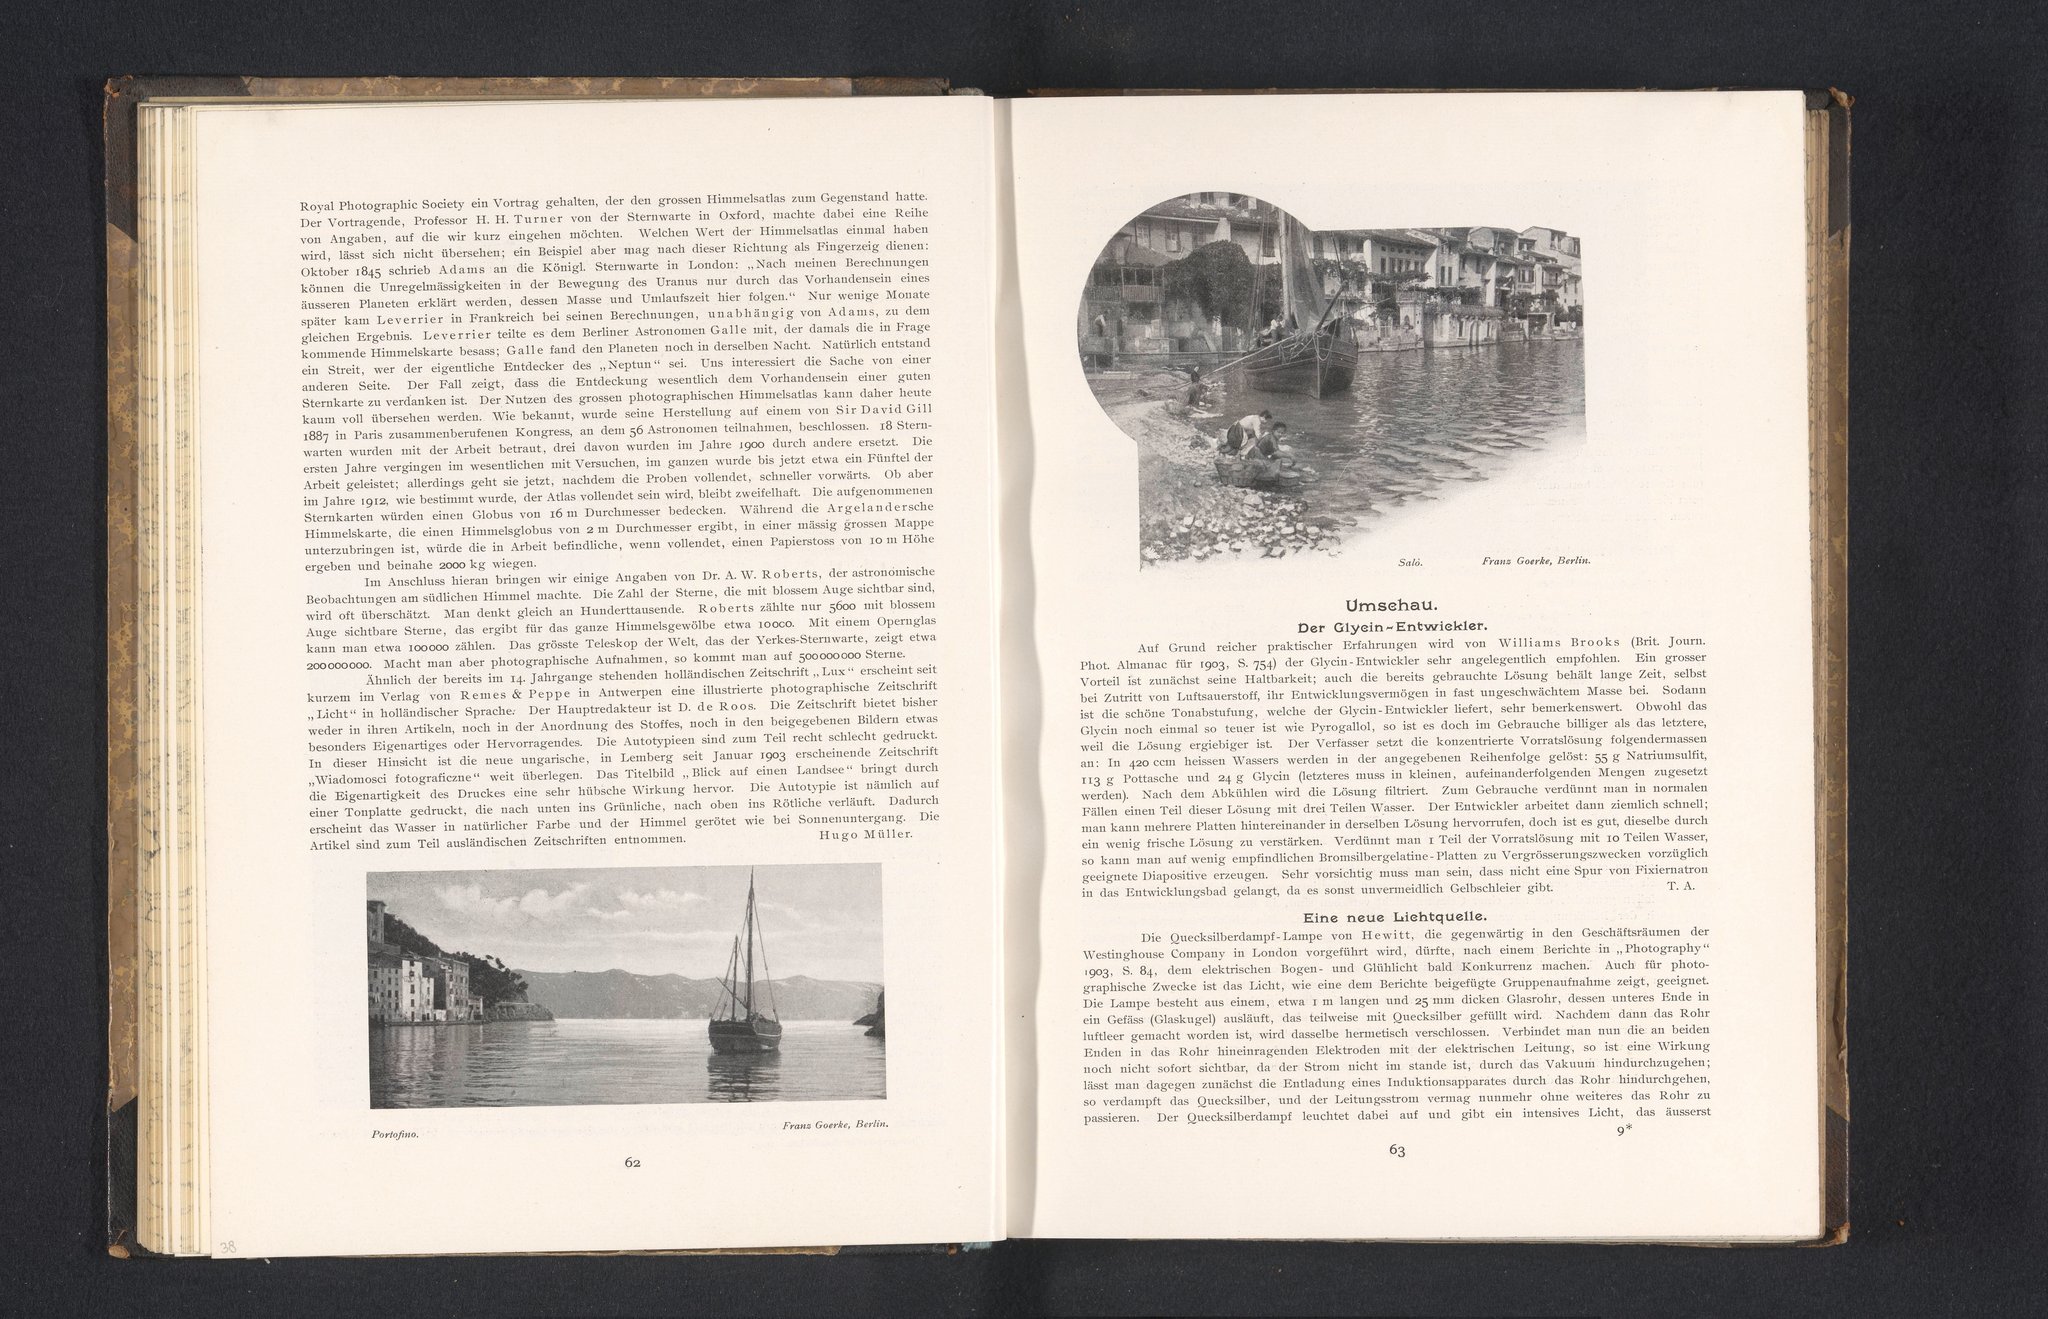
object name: photomechanical print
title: Portofino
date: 1898-1903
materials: paper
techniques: autotype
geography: liguria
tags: city-view, and landscape with man-made constructions, sailing-ship, sailing-boat, mountains, liguria